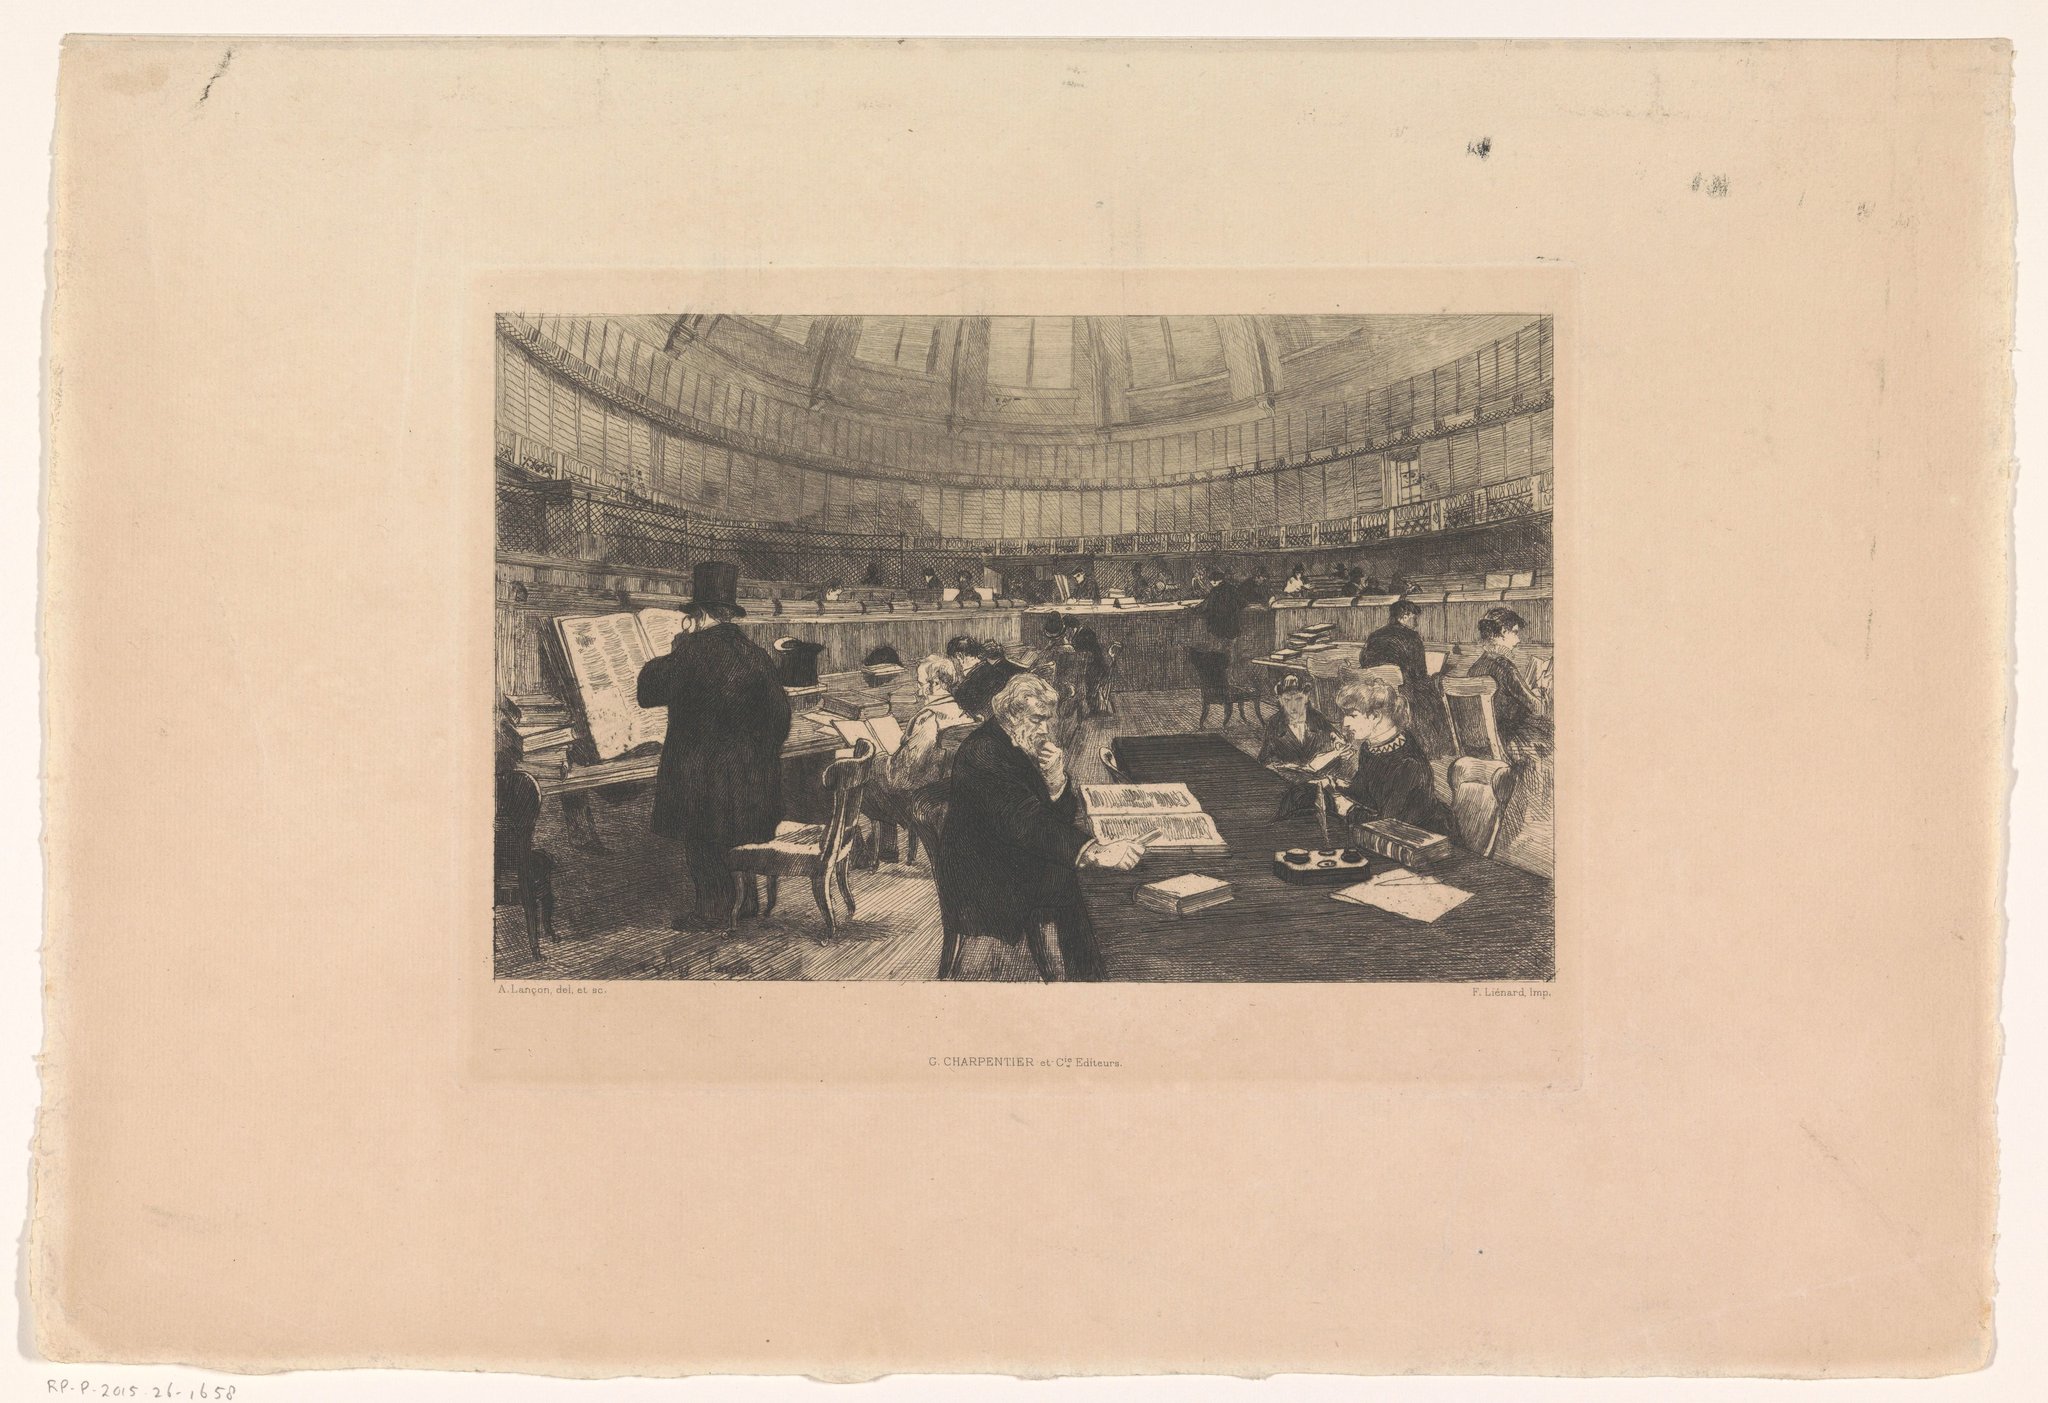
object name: print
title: Leeszaal van het British Museum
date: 1869-1887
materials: paper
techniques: drypoint, etching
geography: paris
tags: writing-table, writing-desk, reading, public library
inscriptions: collector's mark: Lugt 2228, collector's mark: Lugt 4779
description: Interieur met lezende mannen en vrouwen achter leestafels.